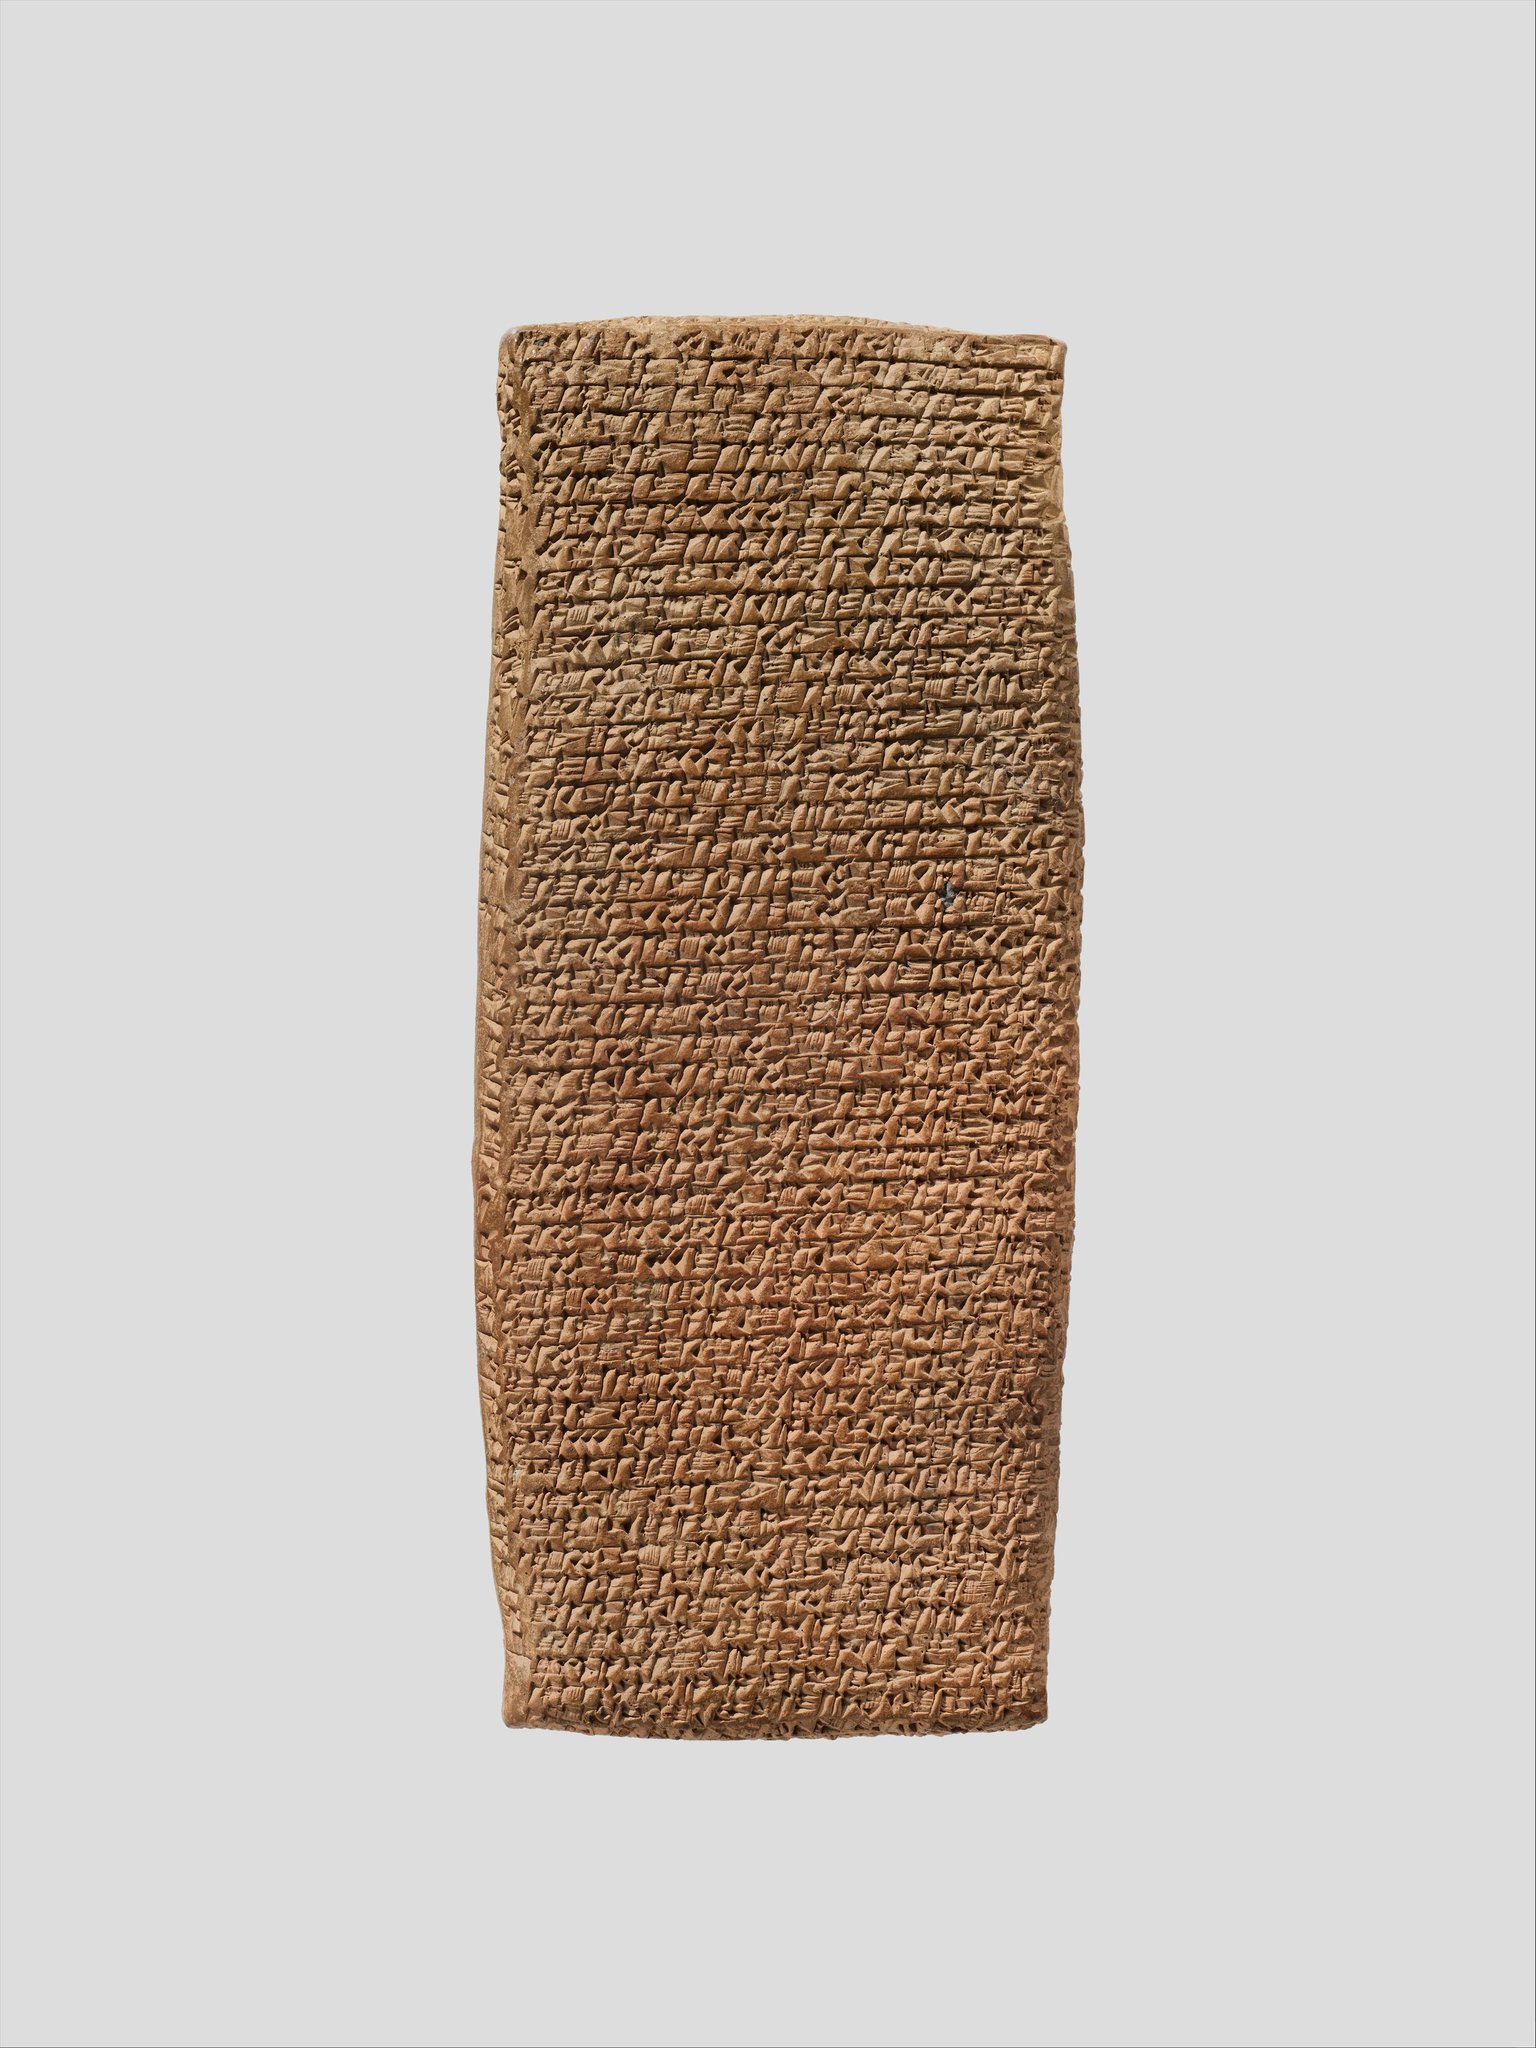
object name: cuneiform tablet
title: Cuneiform tablet: record of a lawsuit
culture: assyrian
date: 2000-1801 BCE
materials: clay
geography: anatolia